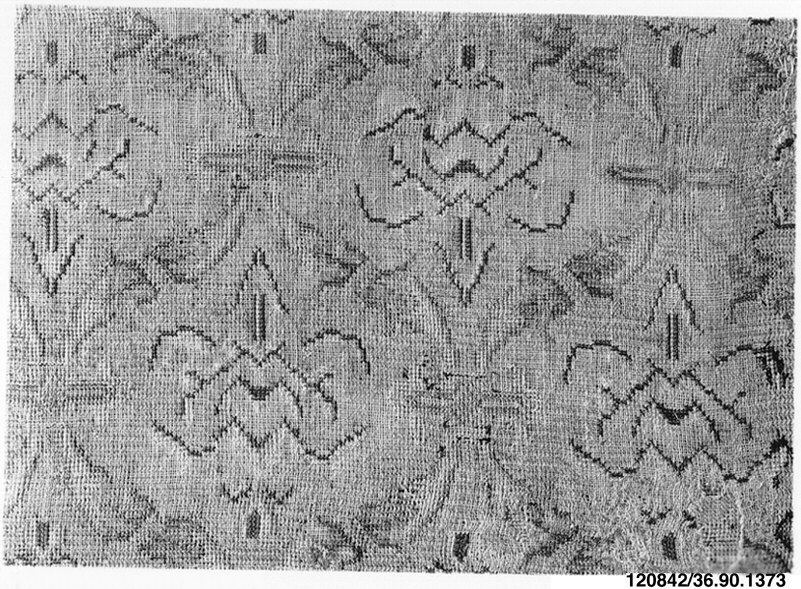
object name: piece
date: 1501-1600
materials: canvas, silk